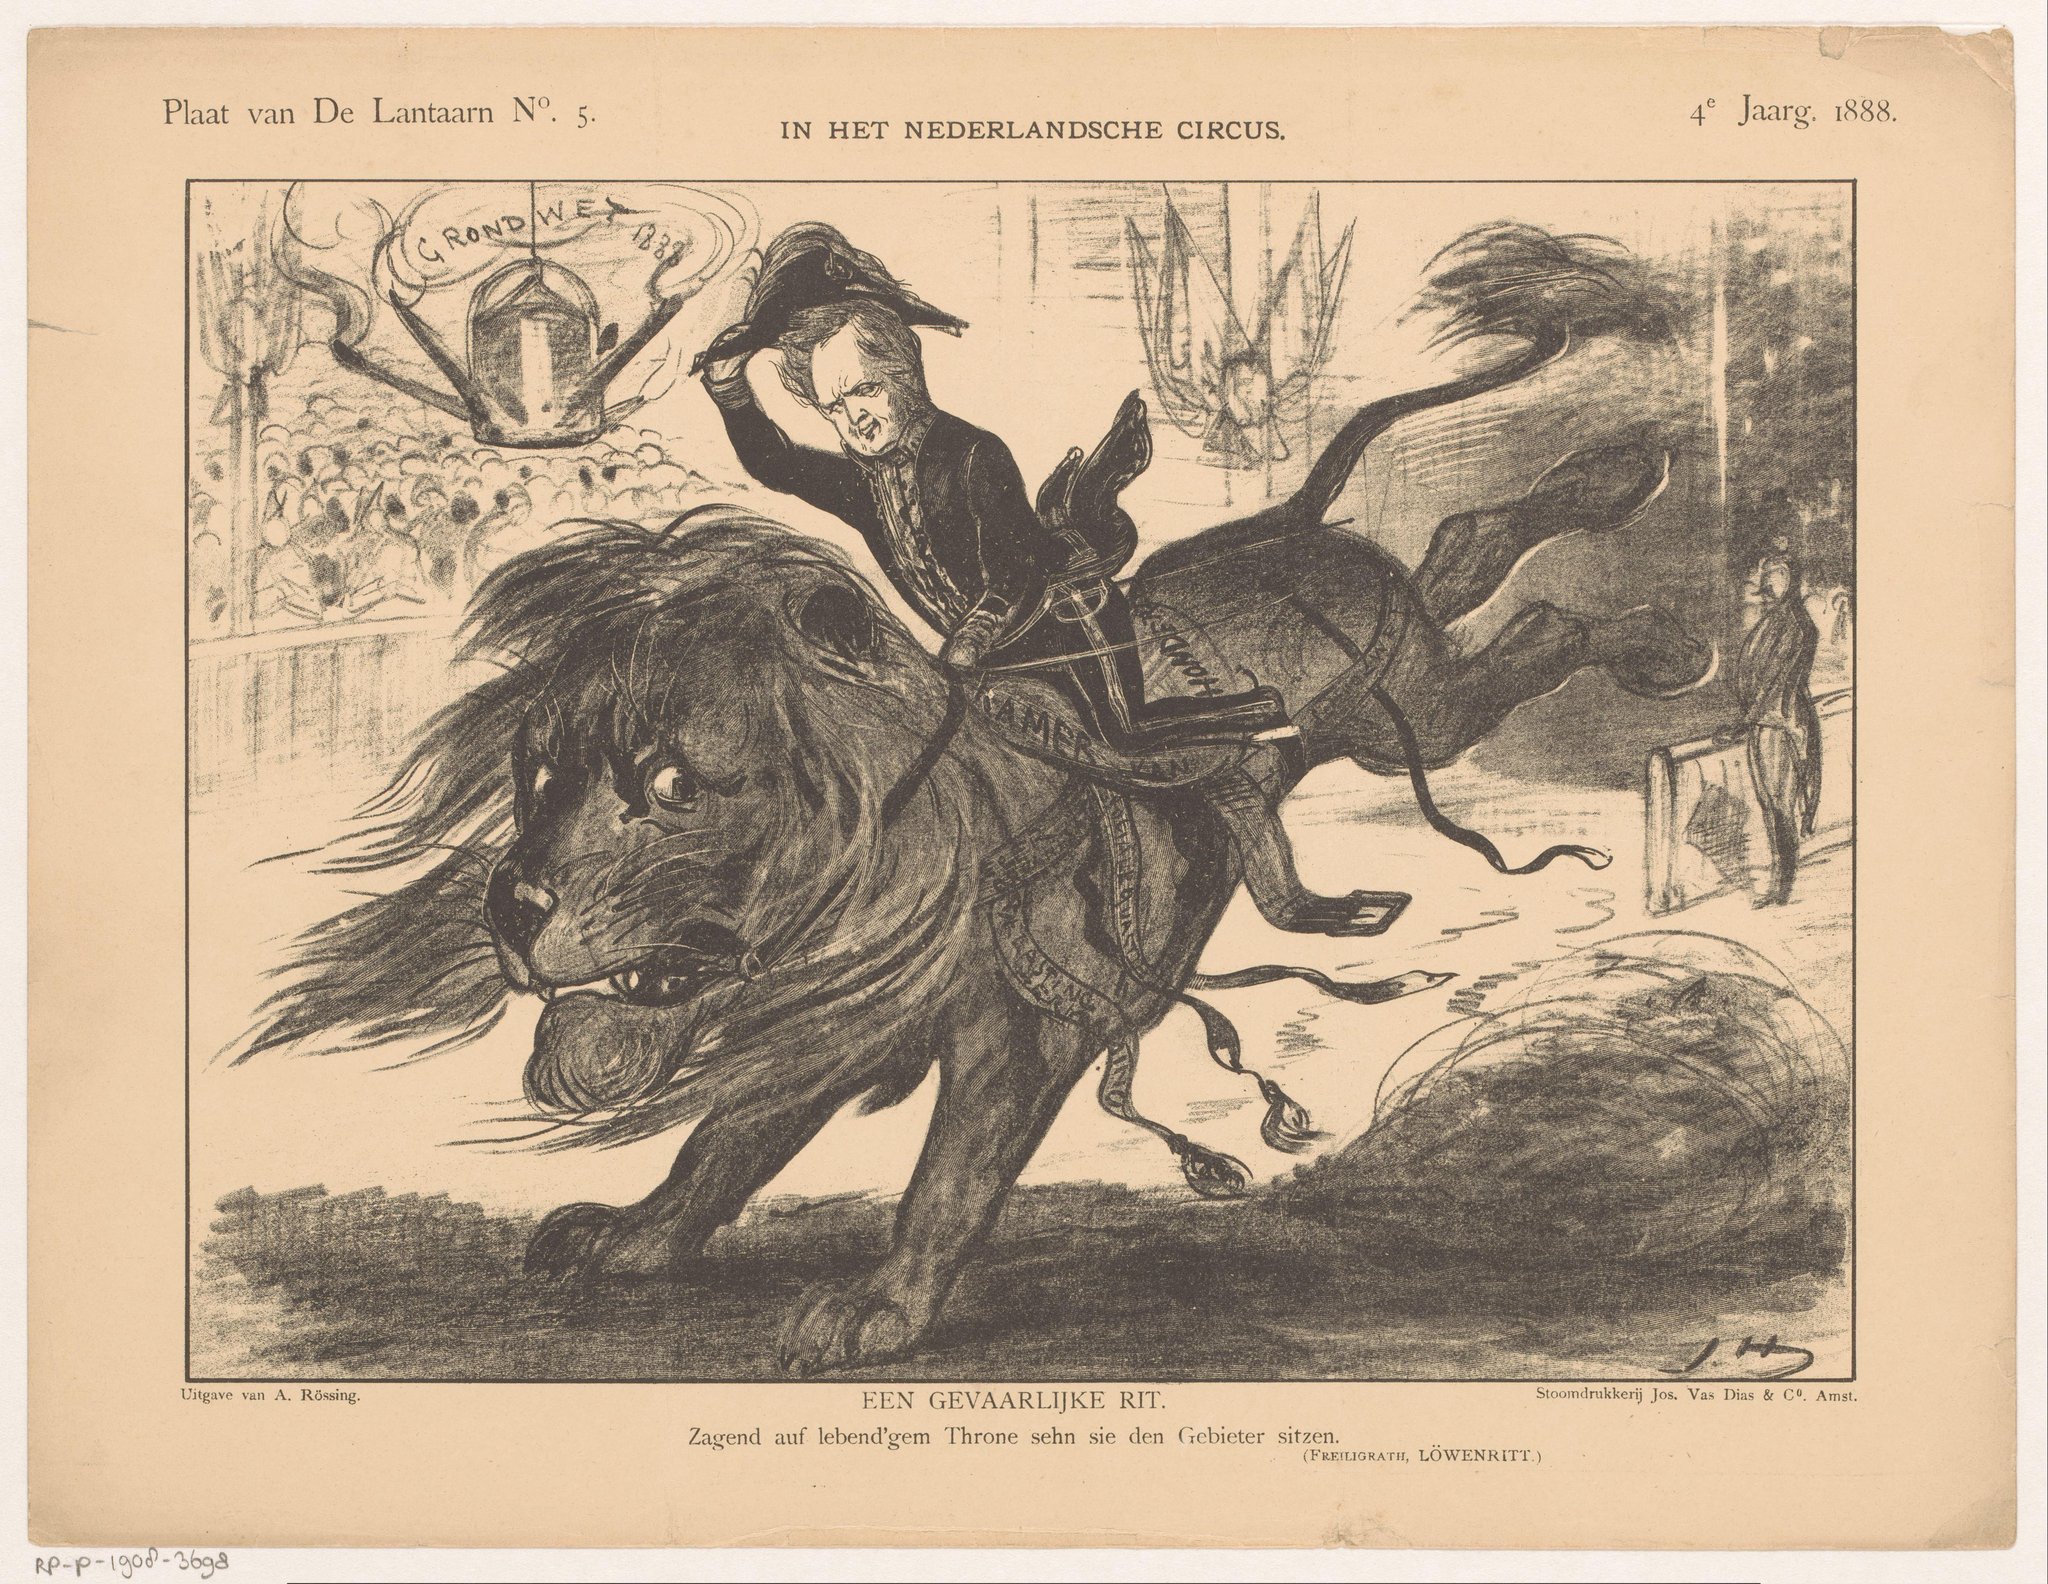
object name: print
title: Spotprent over wijzigingen in de grondwet in 1888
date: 1888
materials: paper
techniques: lithograph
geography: the hague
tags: beasts of prey, predatory animals: lion, political caricatures and satires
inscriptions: collector's mark: Lugt 2228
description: Een man berijdt, in het midden van een circuspiste, een wilde leeuw. Op het zadel staan de woorden: 'kamer van 100' een verwijzing naar een van de veranderingen die met de Tweede Kamerverkiezingen in 1888 werden doorgevoerd, namelijk dat het aantal leden van de Tweede Kamer op 100 werd gebracht. Onder de prent een citaat uit het gedicht Löwenritt van Ferdinand Freiligrath. Deze prent werd uitgegeven bij De Lantaarn.